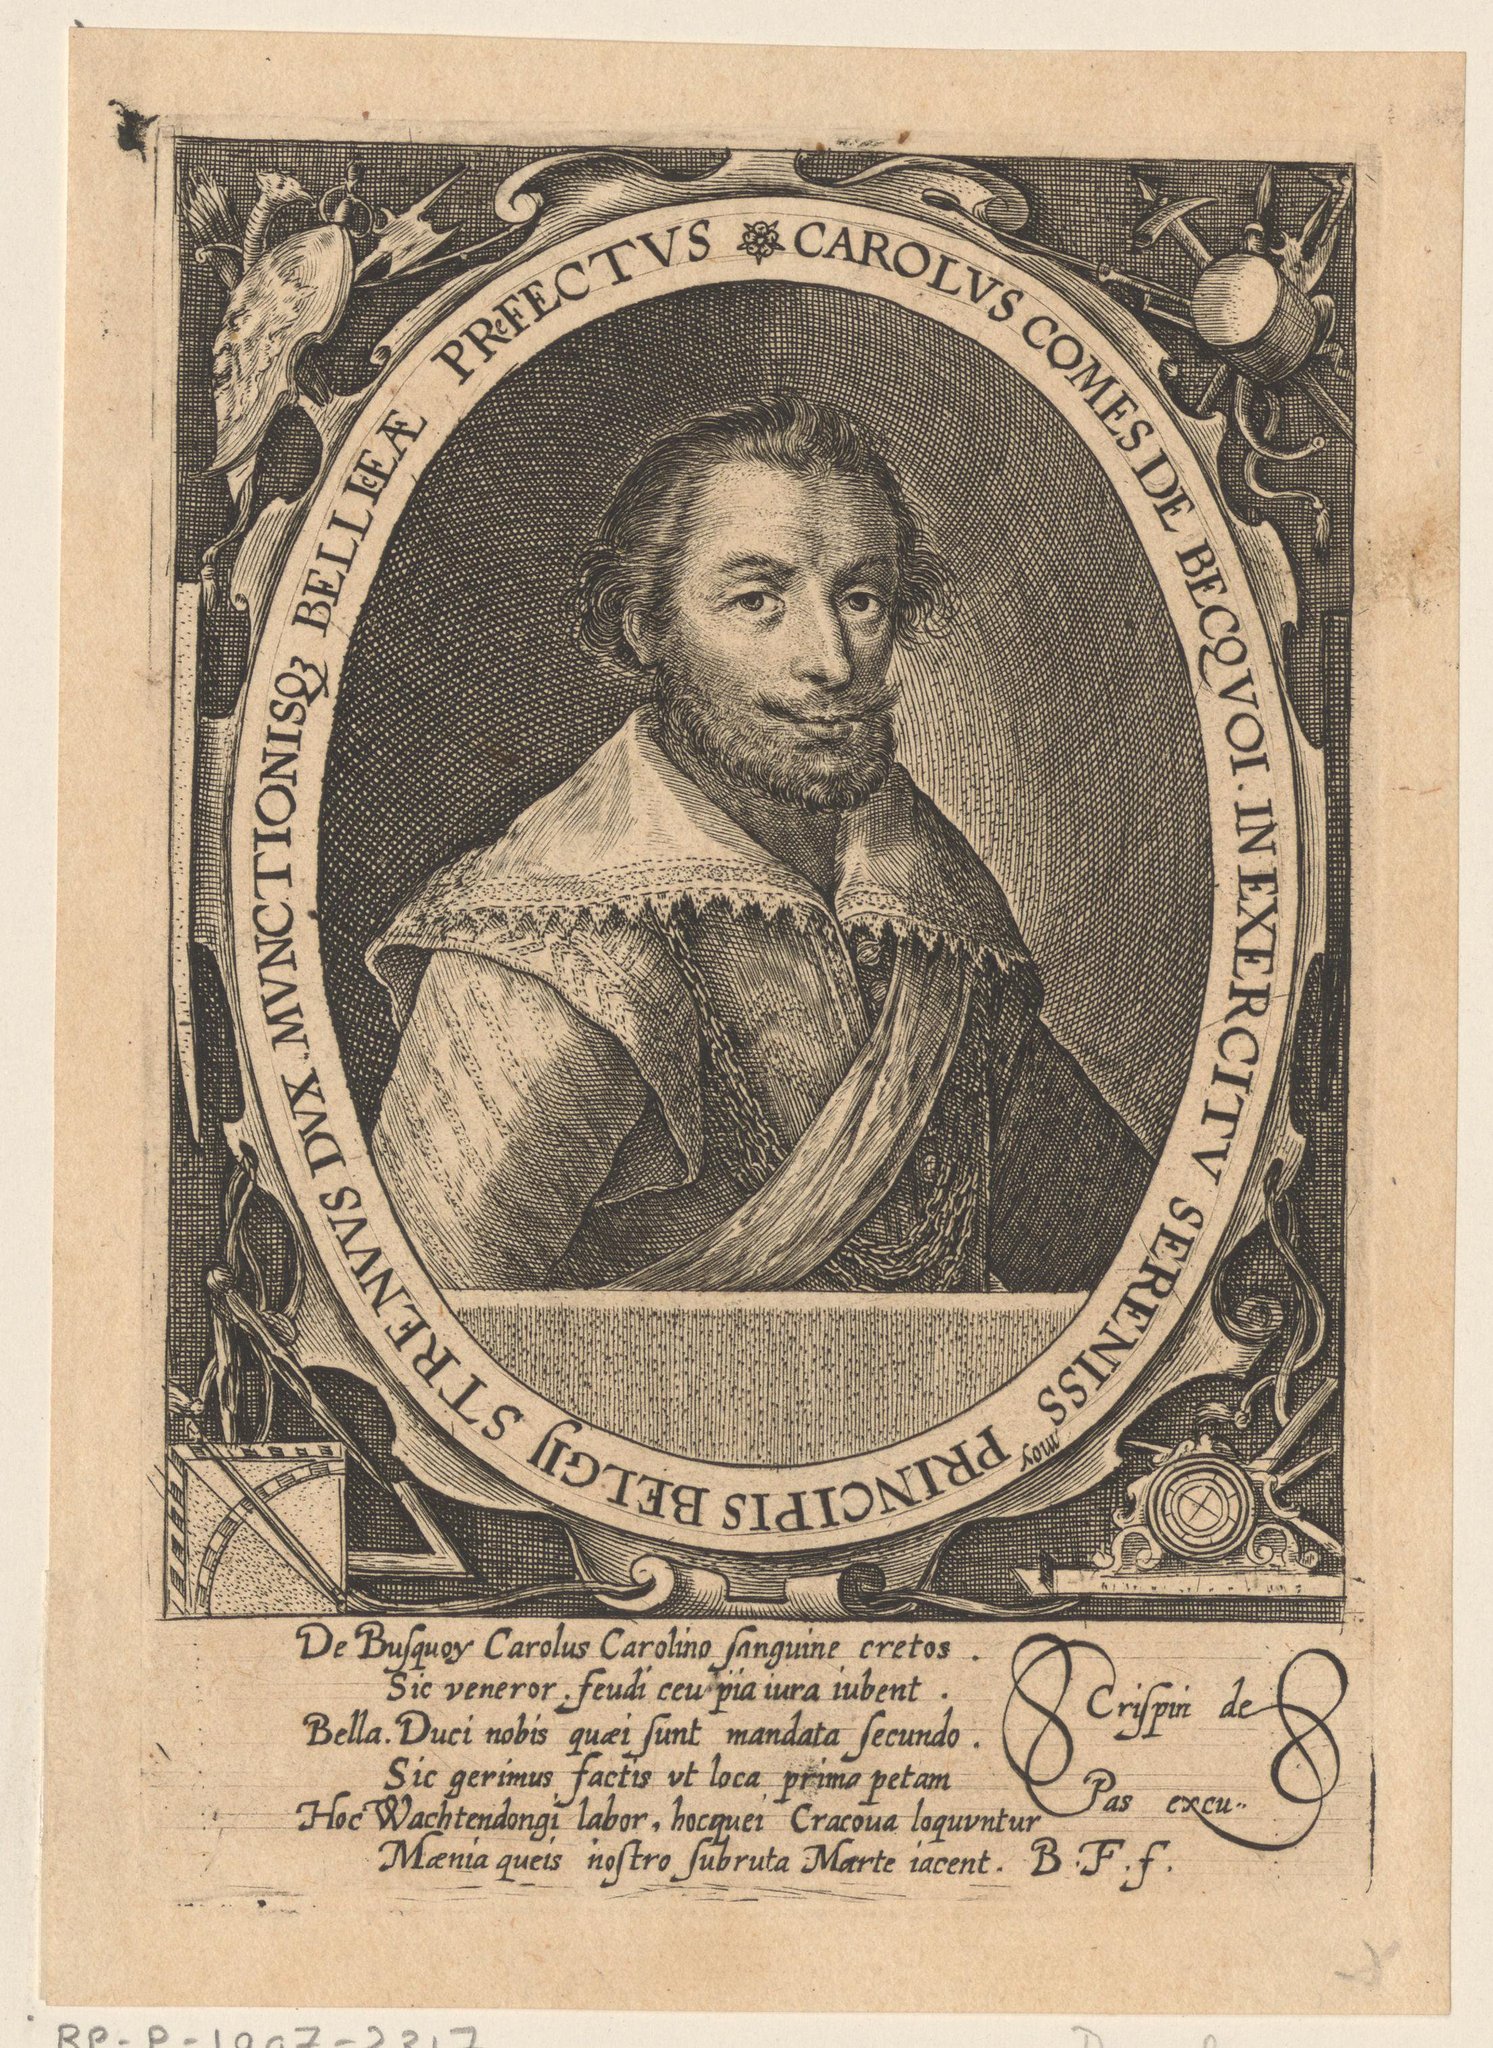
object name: print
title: Portret van Karel Bonaventura van Longueval, graaf van Bucquoy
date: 1601-1637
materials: paper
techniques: engraving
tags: historical persons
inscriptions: collector's mark: Lugt 2228